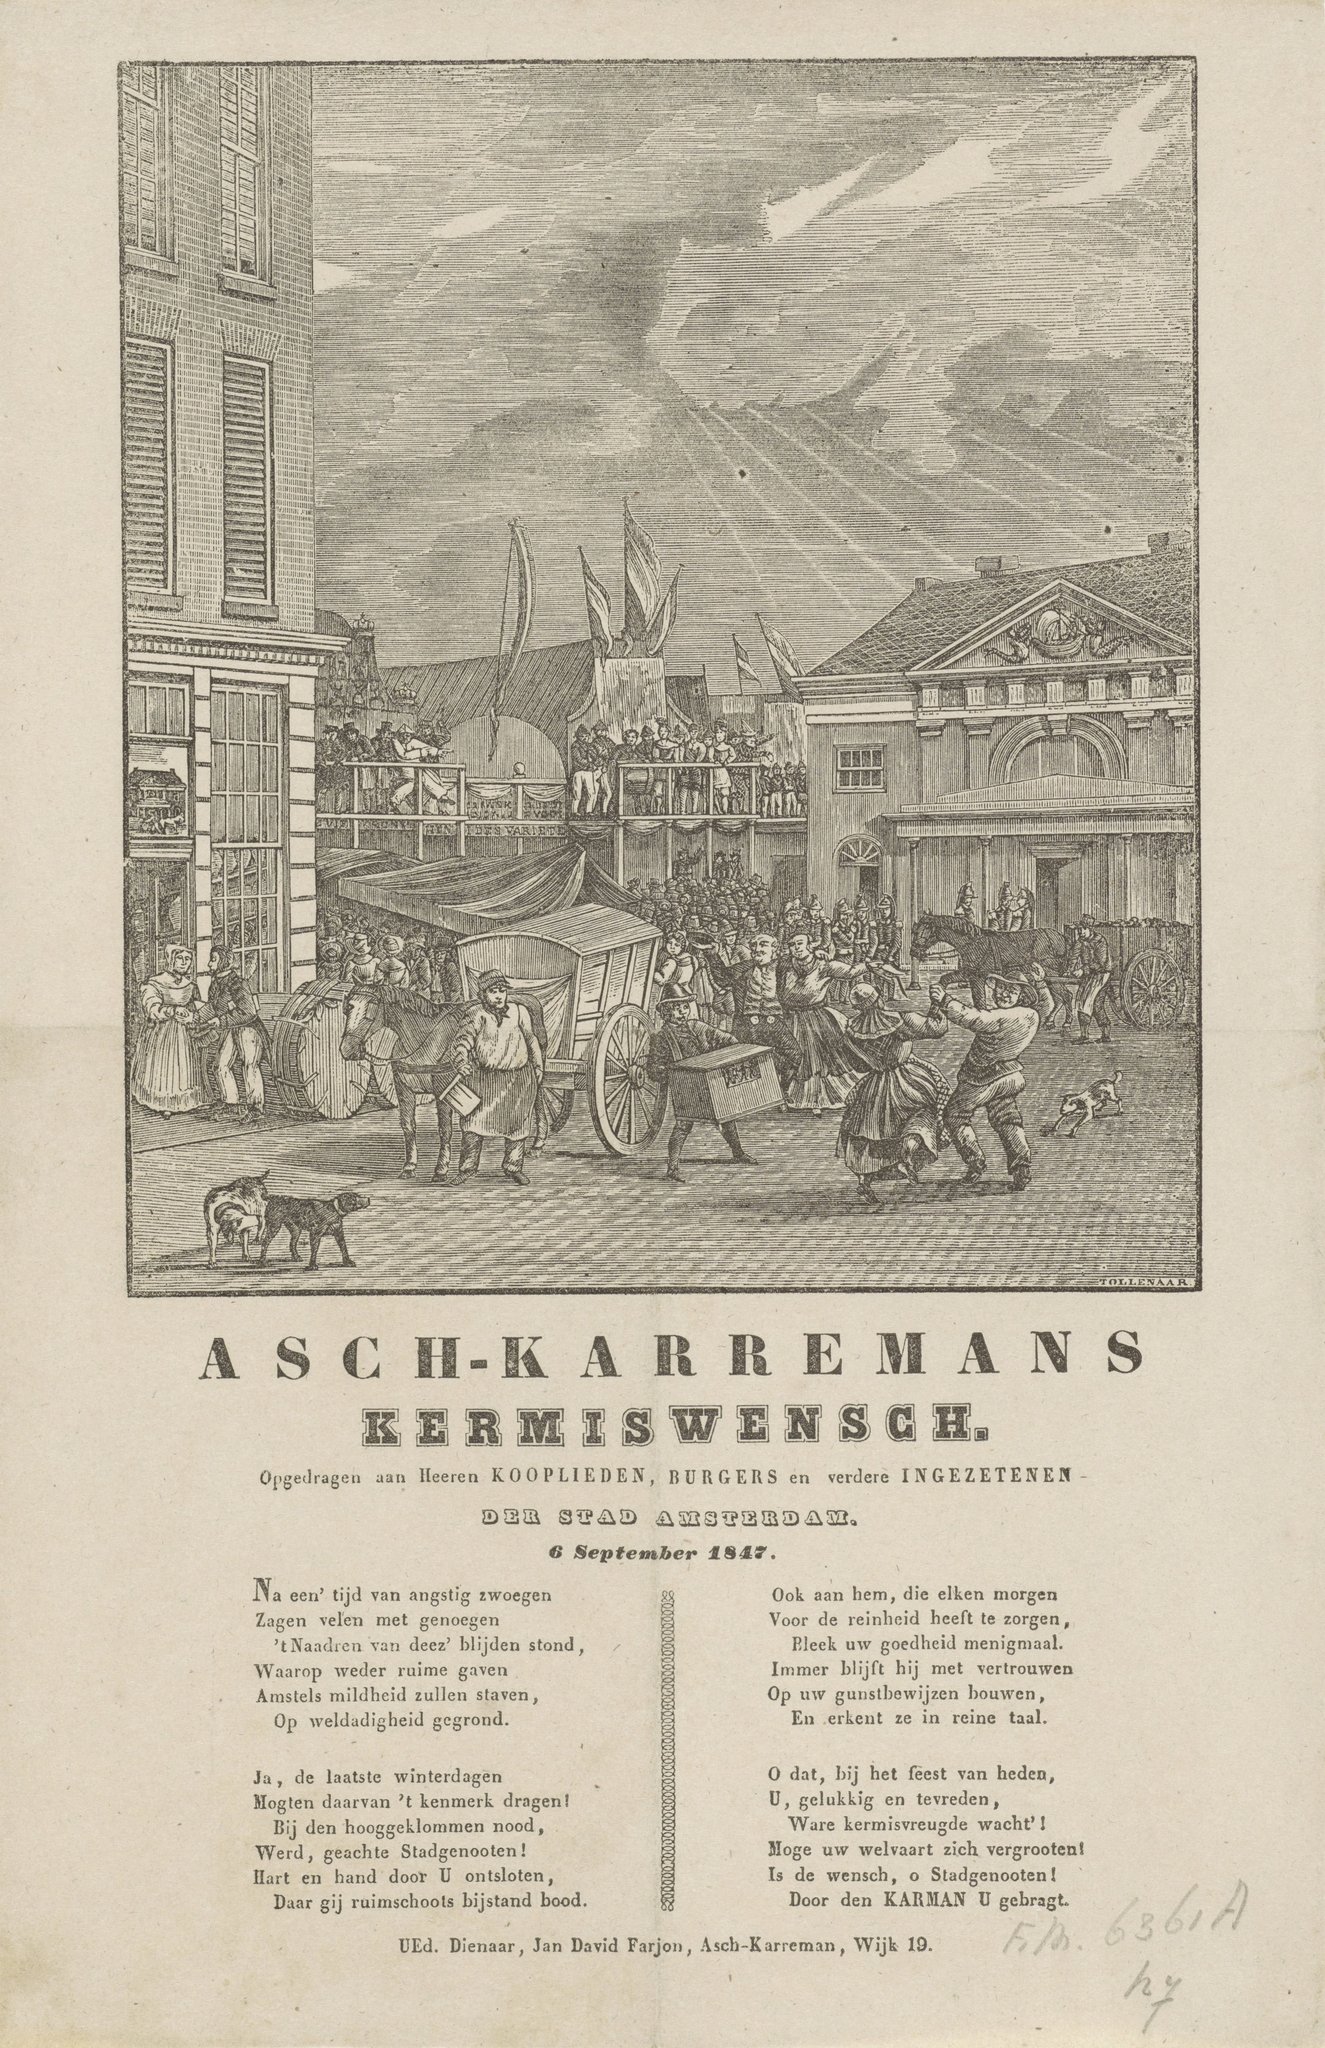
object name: fair print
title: Kermisprent van de Amsterdamse askarrenmannen voor het jaar 1847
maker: dirk wijbrand tollenaar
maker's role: print maker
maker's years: 1808-1858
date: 1847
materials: paper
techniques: letterpress printing, engraving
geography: amsterdam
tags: public road - ii - ideal city, pleasure fair and circus, garbage collection, amsterdam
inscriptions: collector's mark: Lugt 2228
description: Kermisprent namens de askarrenmannen (karrenman of vuilnisman) te Amsterdam, 6 september 1847. Gezicht op de kermis op de Botermarkt met de Regulierswaag. Op de markt twee vuilniskarren. Onderaan een gedicht in twee kolommen. Namens Jan David Farjon, de askarreman van wijk no. 19.